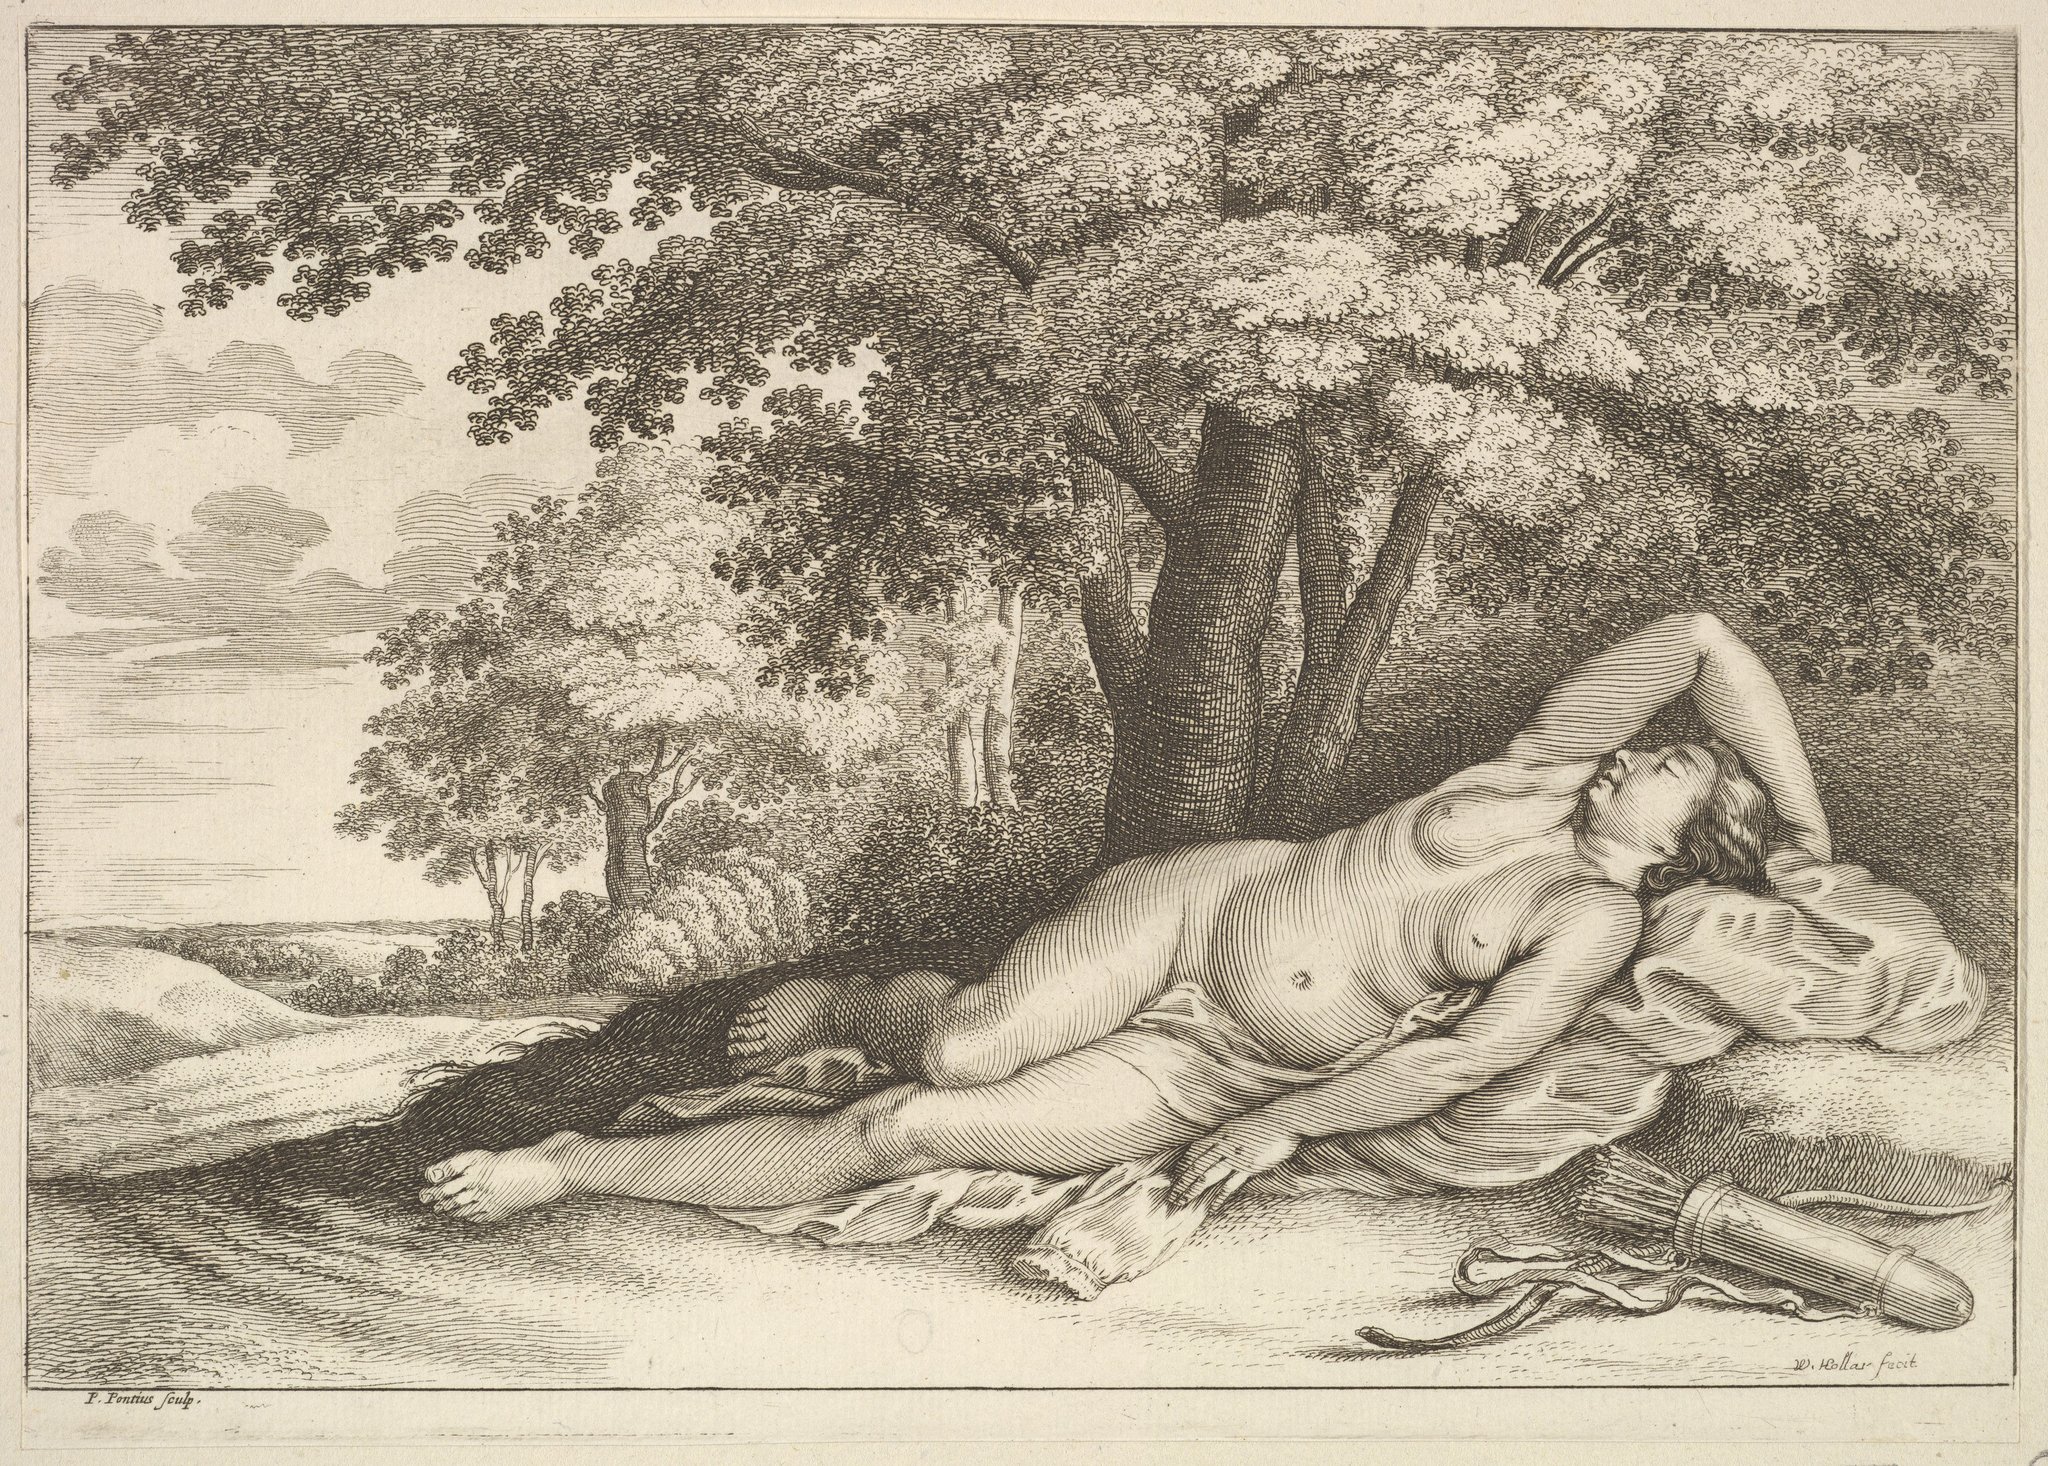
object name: print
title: Sleeping figure of Diana the huntress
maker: wenceslaus hollar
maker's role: artist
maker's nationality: bohemian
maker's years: 1607-1677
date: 1644-1652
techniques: engraving, etching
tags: bow and arrow,sleeping,diana,landscapes,trees